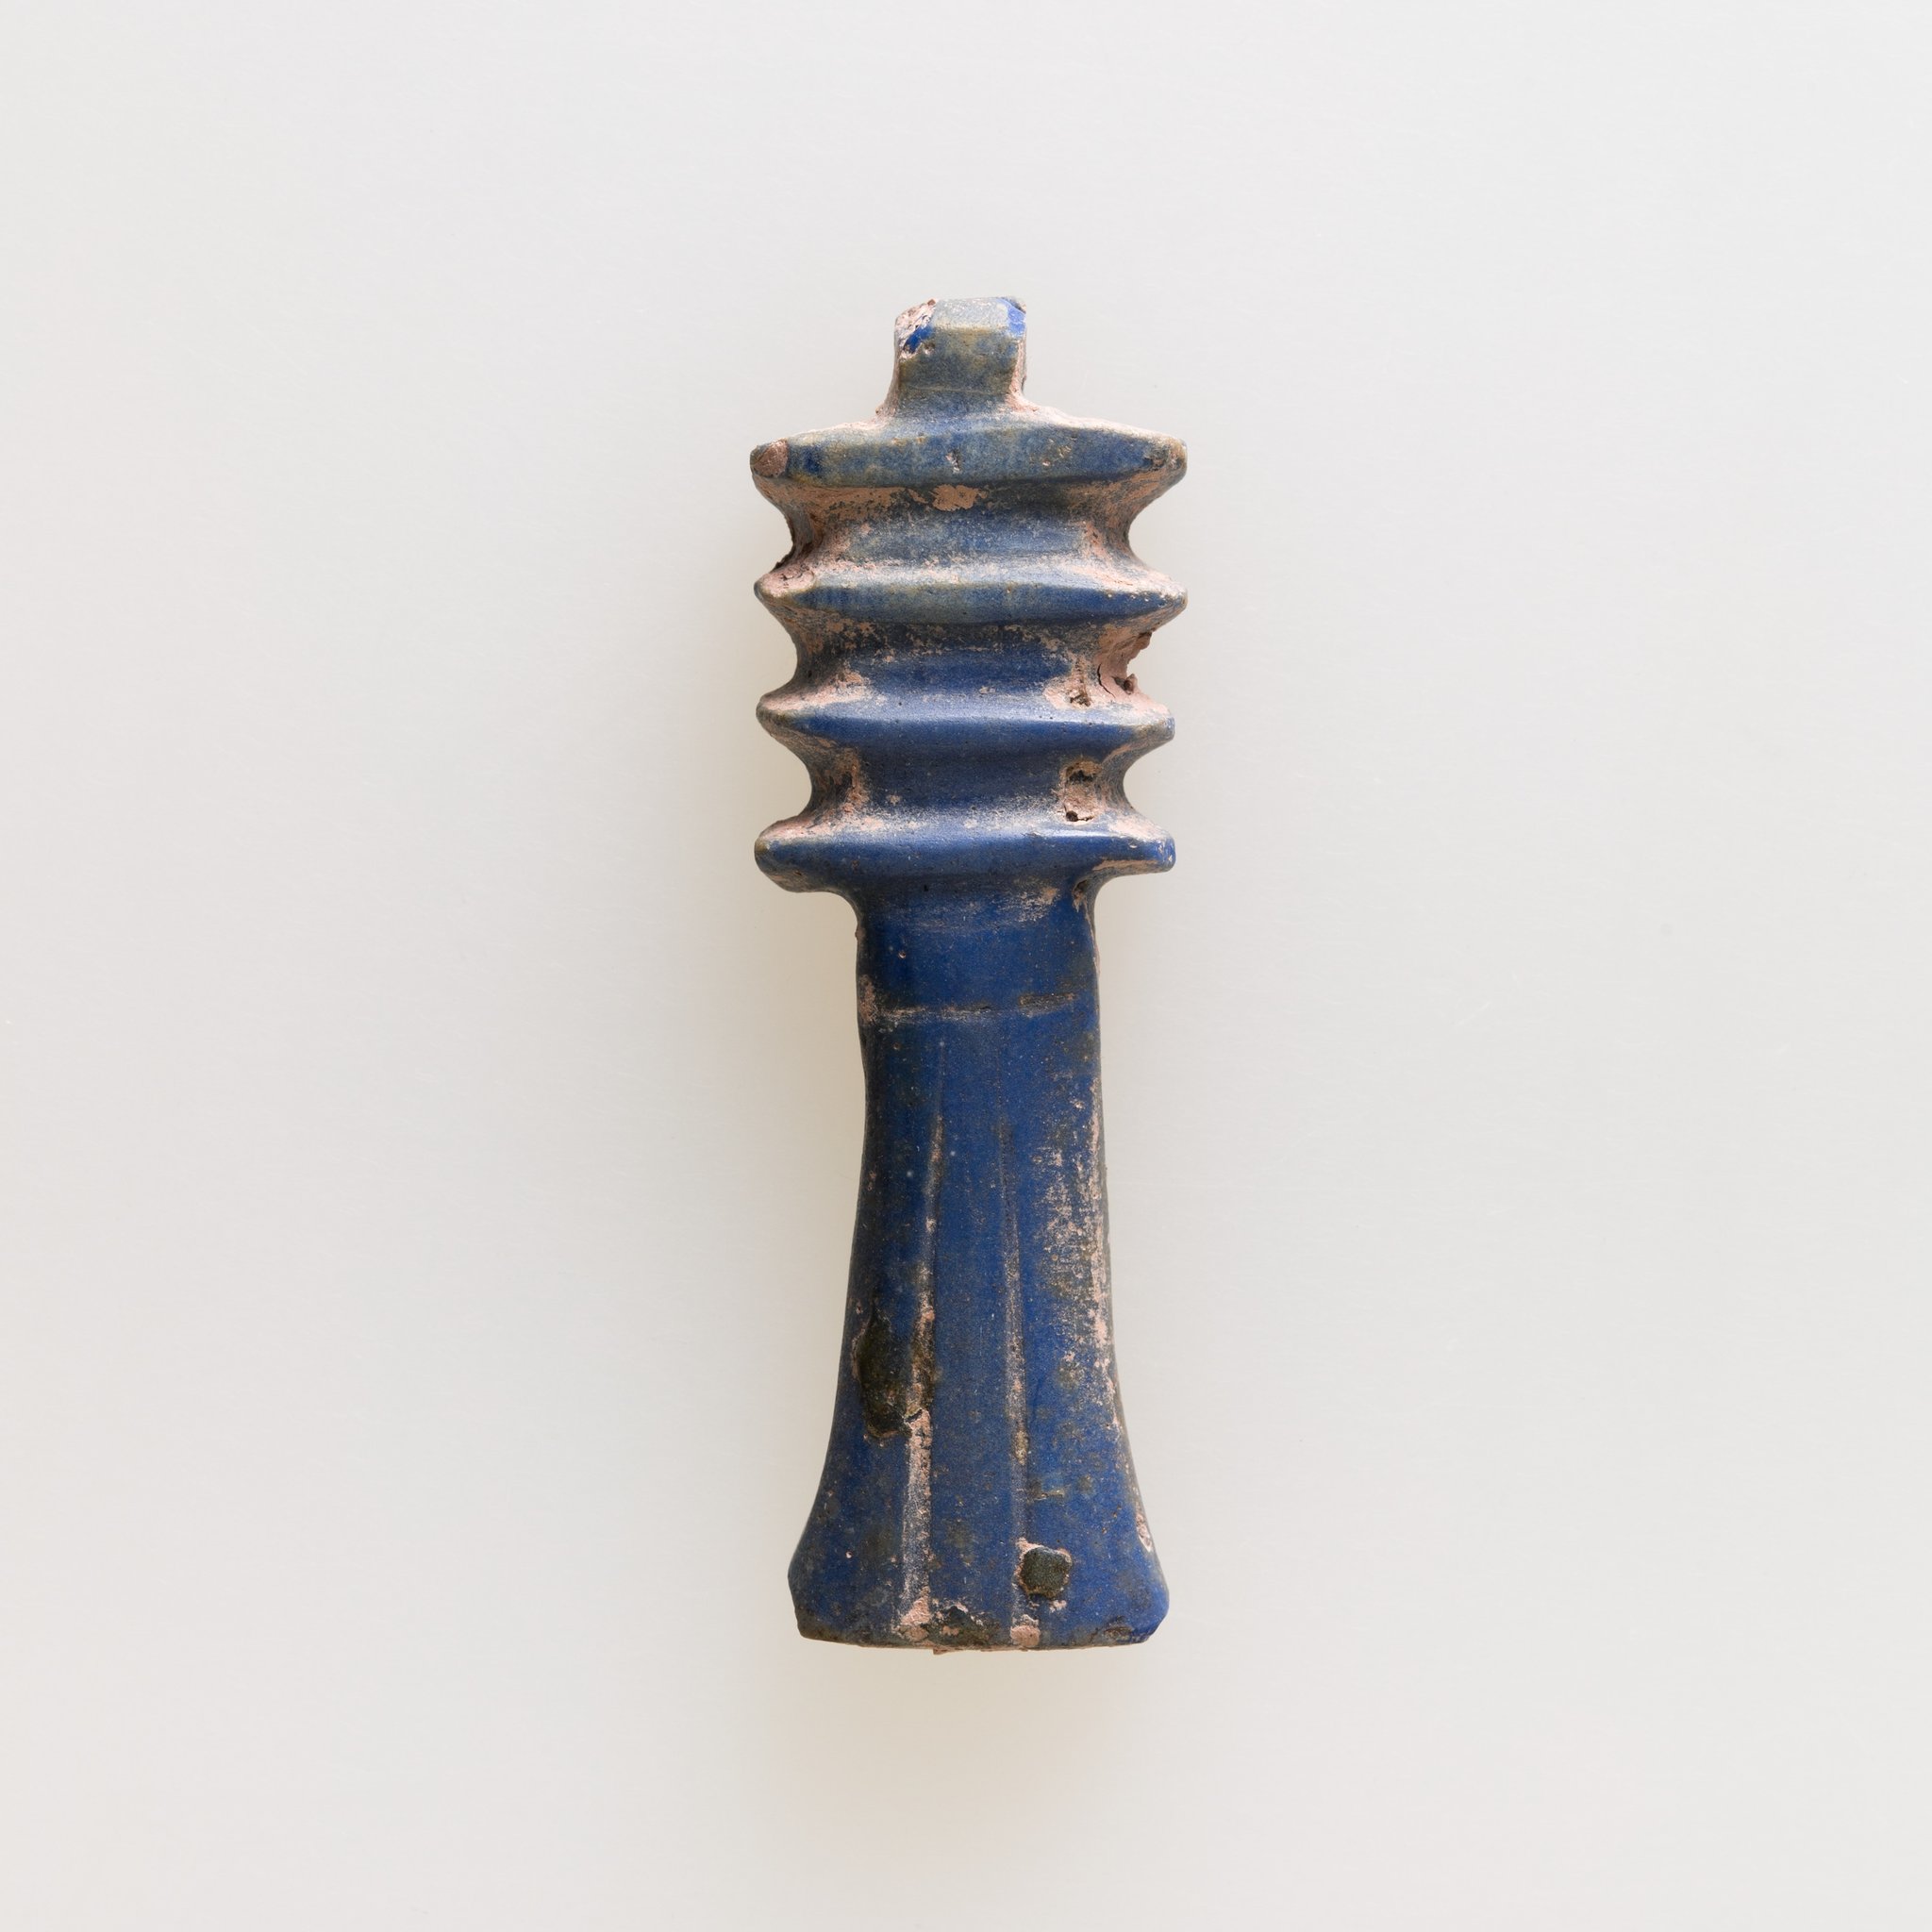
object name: amulet, djed pillar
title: Djed pillar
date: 525-30 BCE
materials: glass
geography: egypt